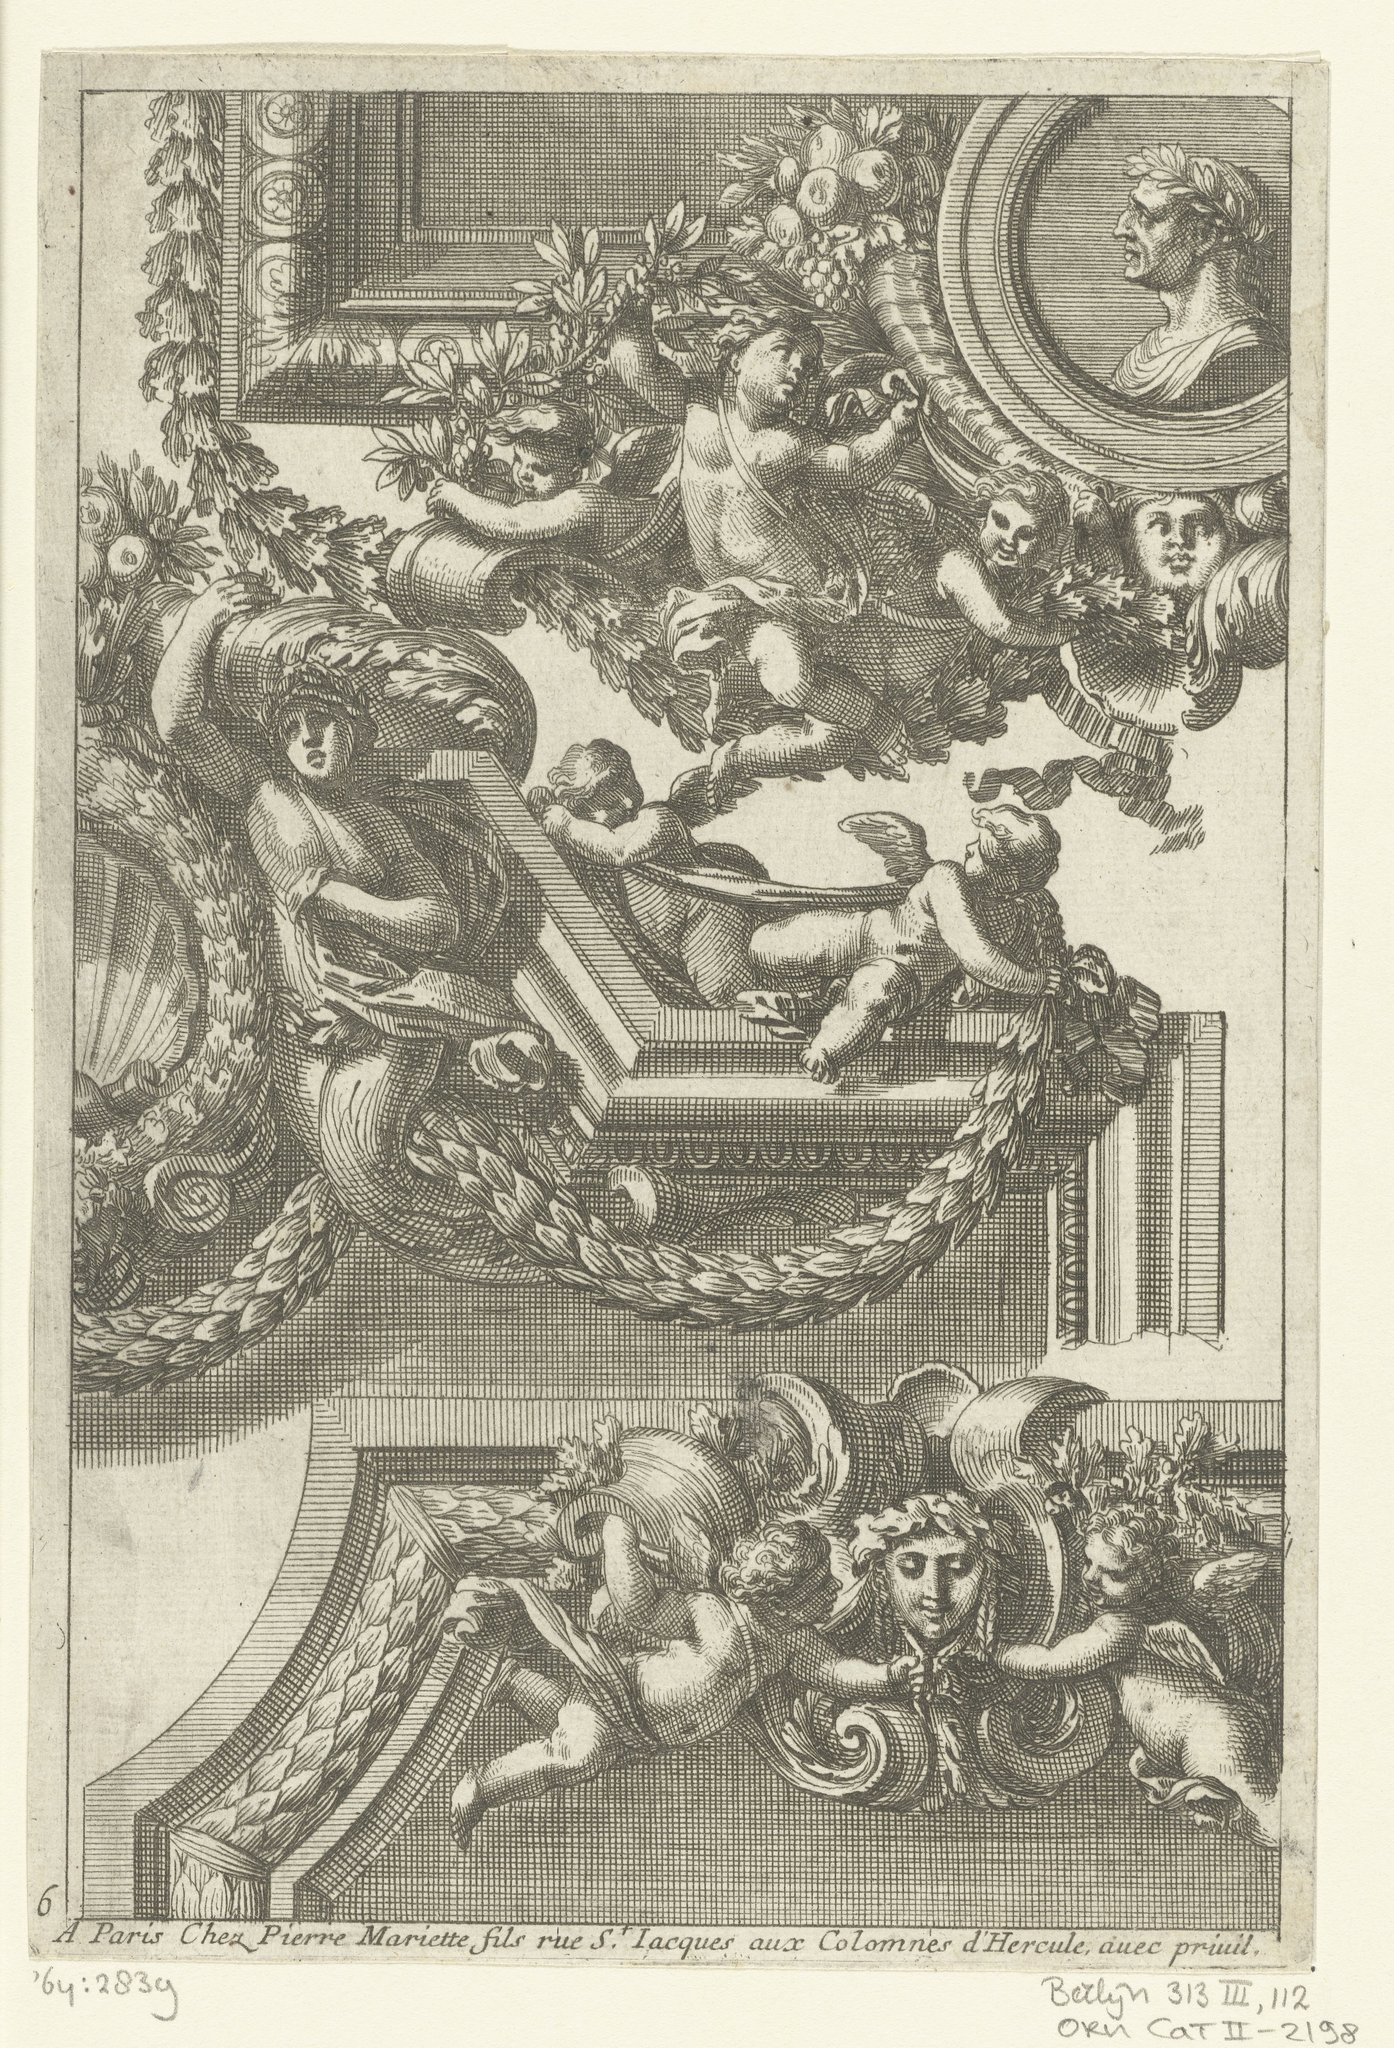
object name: ornament print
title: Drie decoraties voor lijsten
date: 1655-1657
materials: paper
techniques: etching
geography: france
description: Decoraties voor het midden van de boven- of onderkant van lijsten. Uit eerste editie.